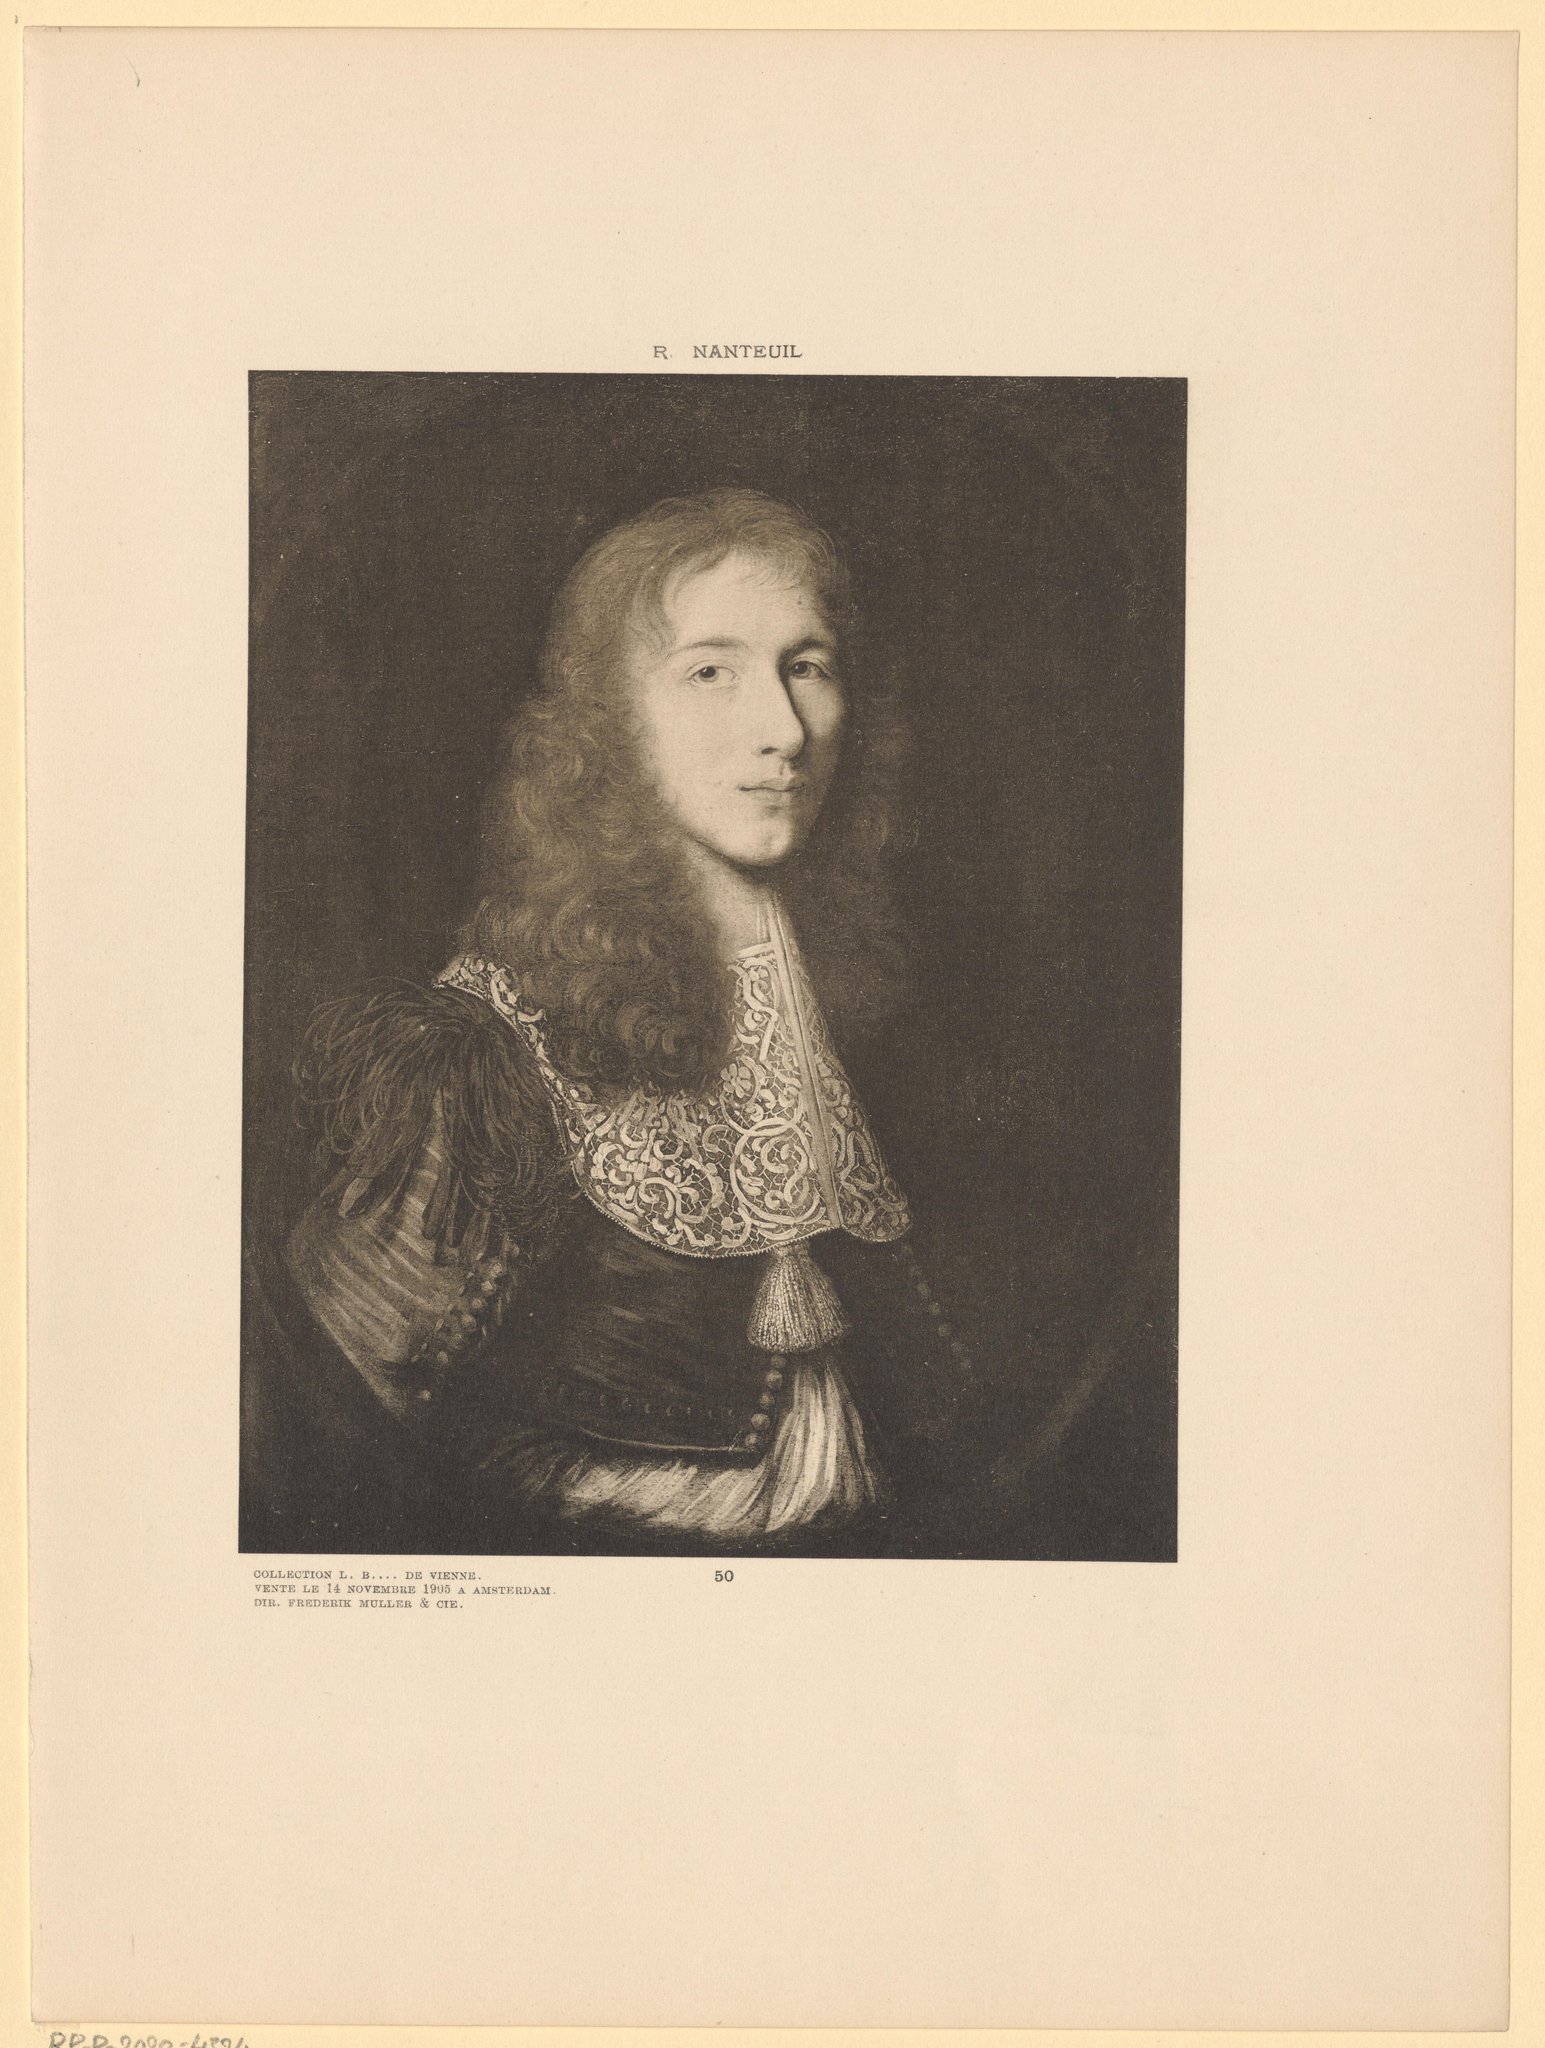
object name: photomechanical print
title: Portret van Henri-Jules de Bourbon, prins van Condé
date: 1905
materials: paper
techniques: photograph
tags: historical persons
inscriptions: date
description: Prent uit: Veilingcatalogus Frederik Muller & Co., 14 november 1905.